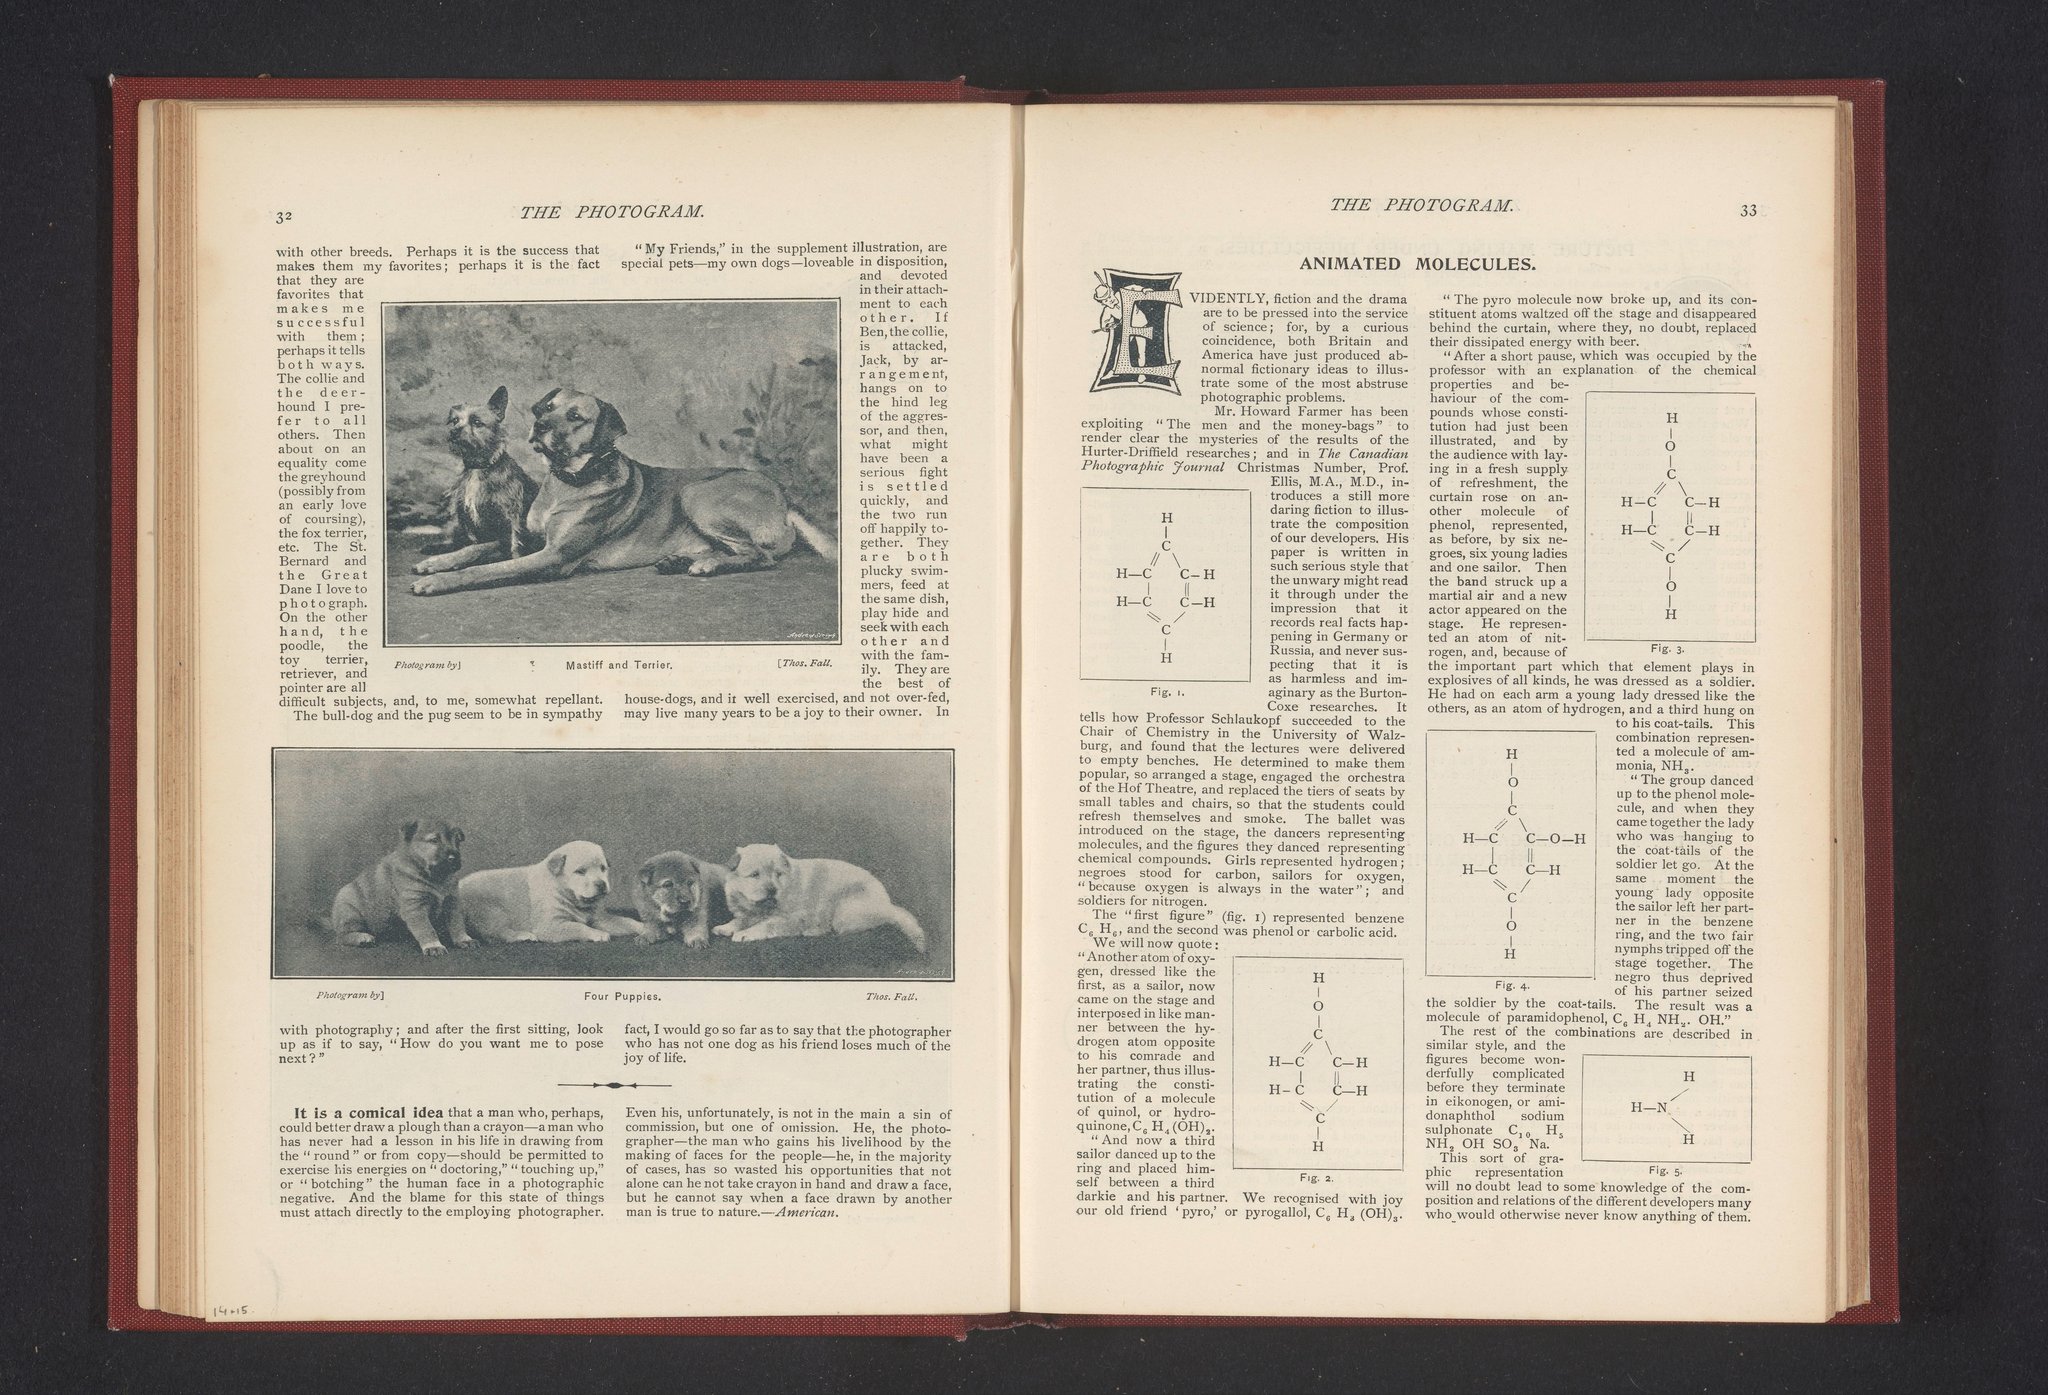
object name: page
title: Vier puppy's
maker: thomas fall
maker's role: fotograaf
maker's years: 1833-1900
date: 1889-1894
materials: paper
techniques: autotype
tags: dog